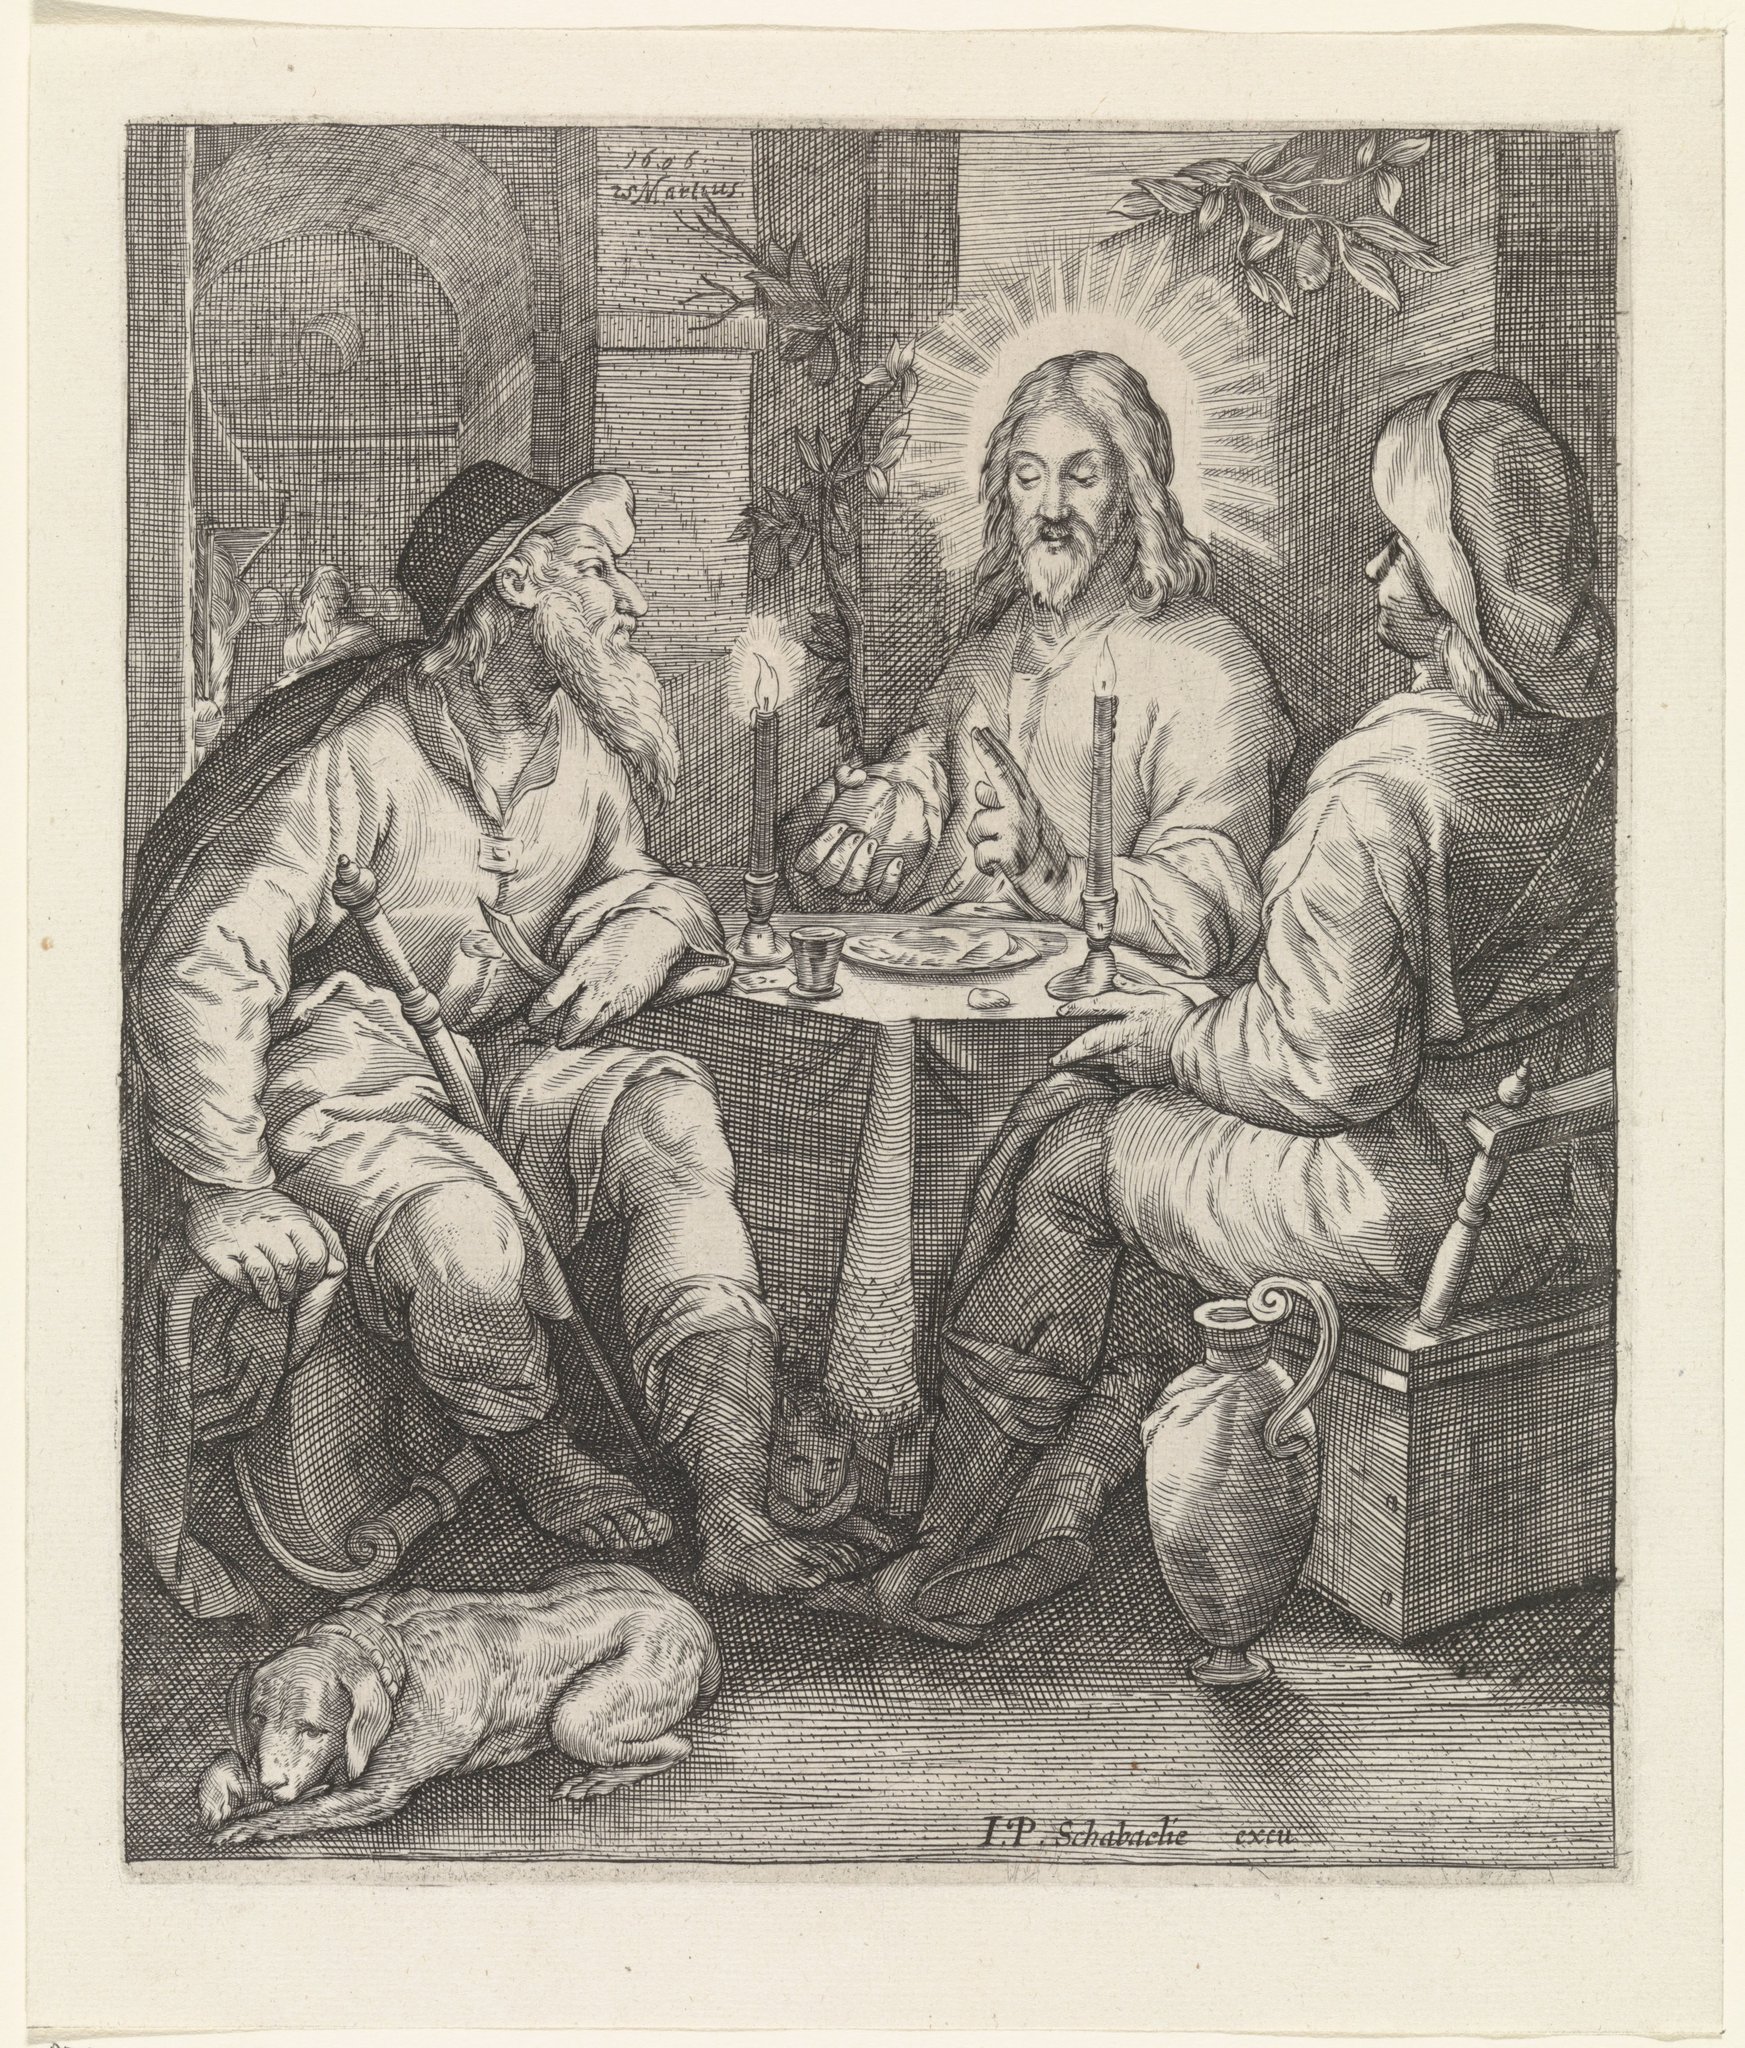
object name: print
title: Maaltijd in Emmaüs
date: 1606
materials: paper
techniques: engraving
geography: amsterdam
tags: the supper at emmaus: christ is recognized while blessing or breaking the bread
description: Christus met de Emmaüsgangers aan tafel, terwijl hij het brood zegent.